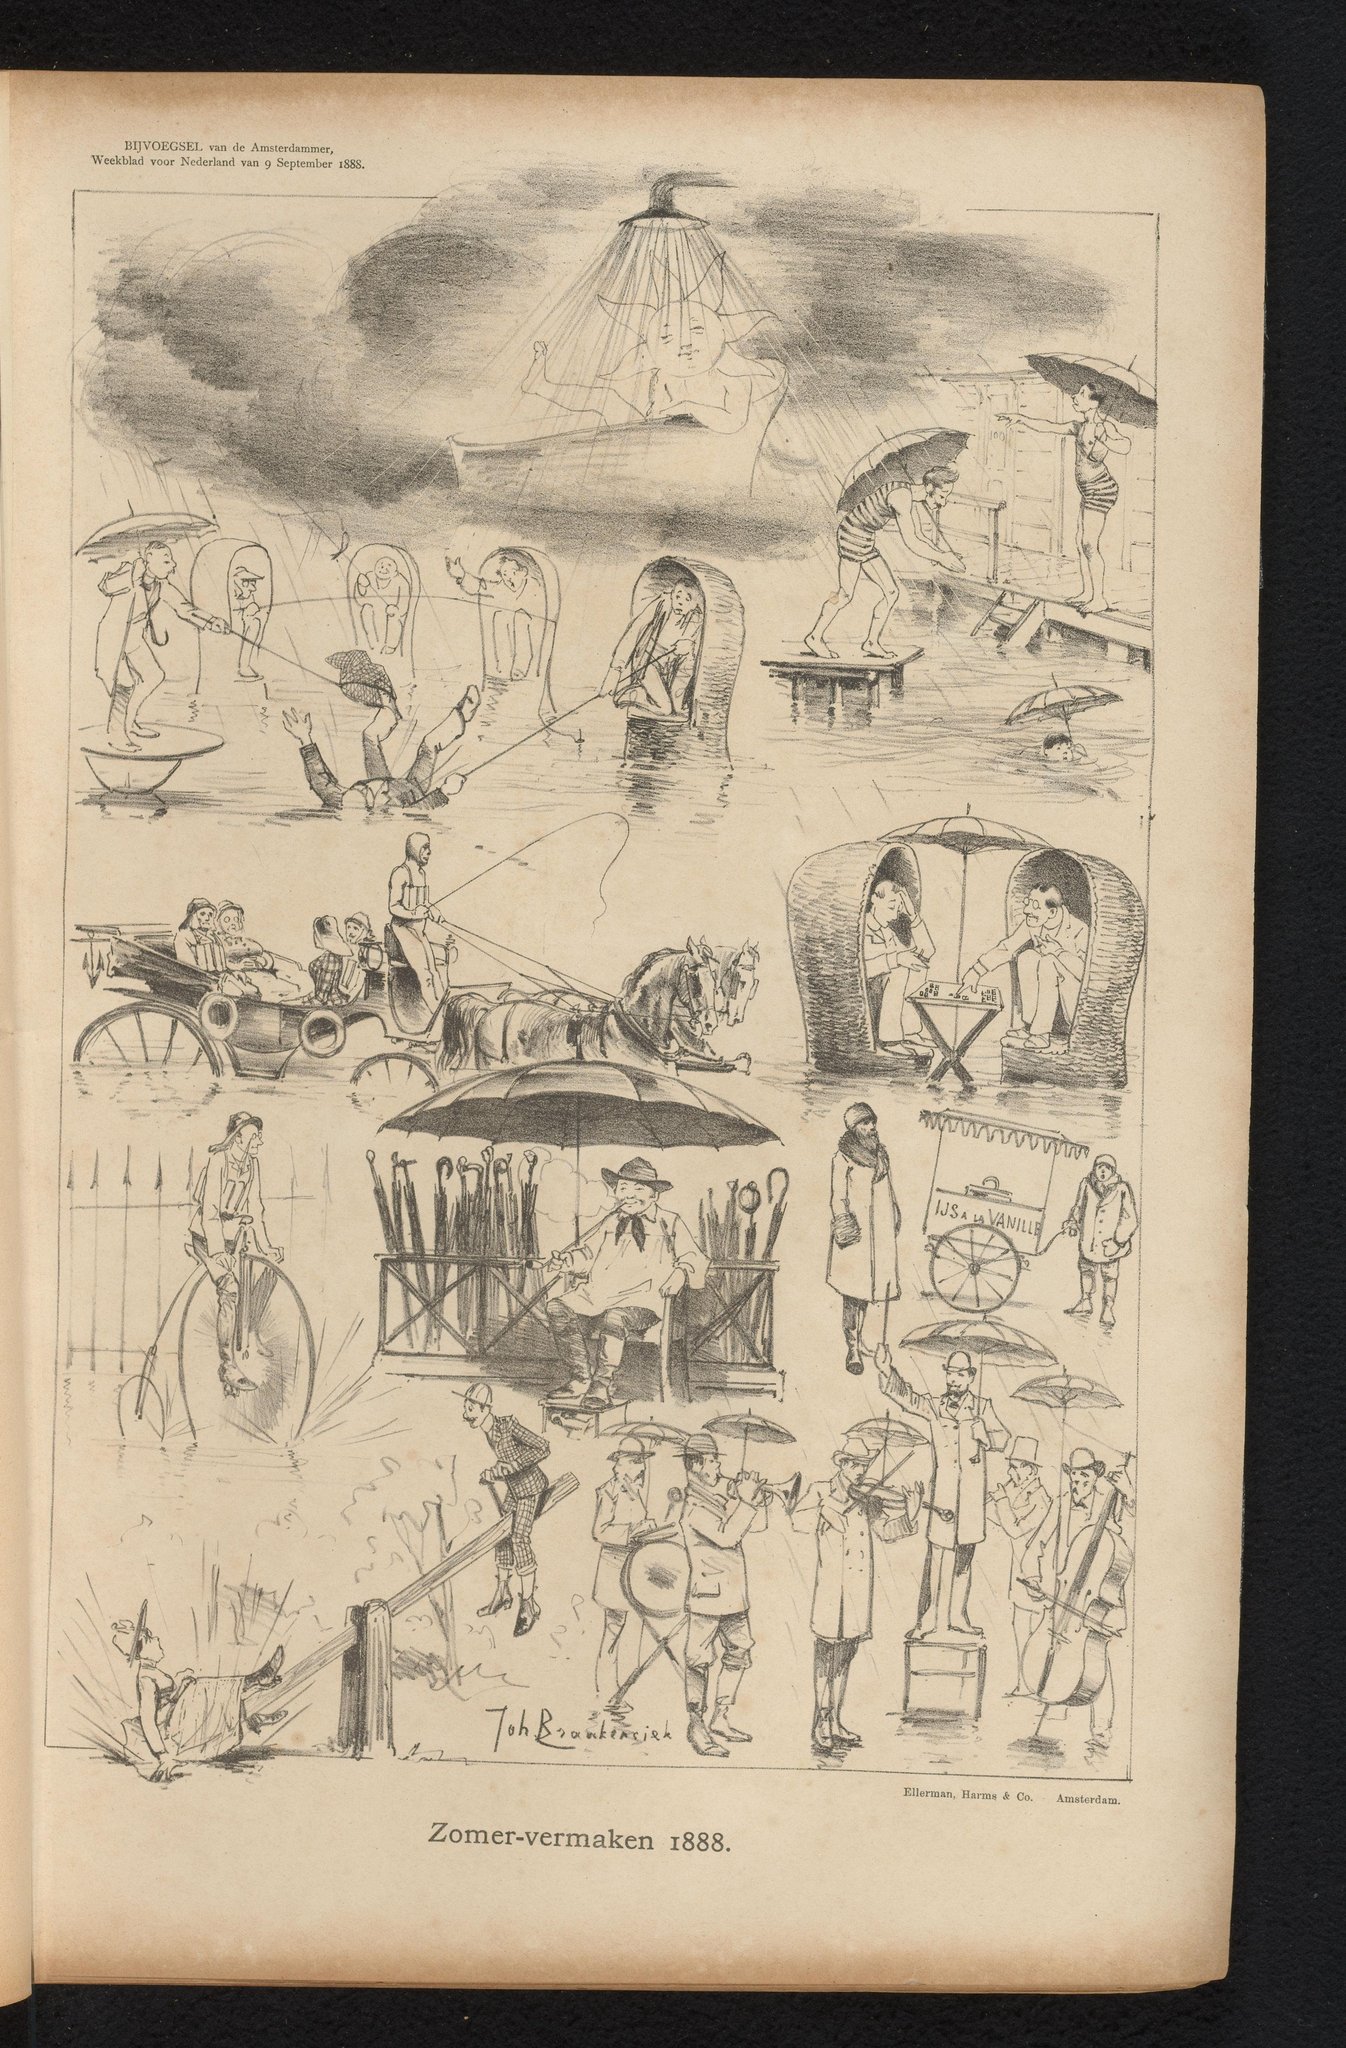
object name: cartoon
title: Zomer-vermaken 1888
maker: johan braakensiek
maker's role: draughtsman, print maker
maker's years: 1858-1940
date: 1888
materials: paper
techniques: lithograph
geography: amsterdam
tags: summer ~ human activities (the four seasons of the year), rain, flood, political caricatures and satires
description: Blad met meerdere humoristische scènes van de wateroverlast in de verregende zomer van 1888.